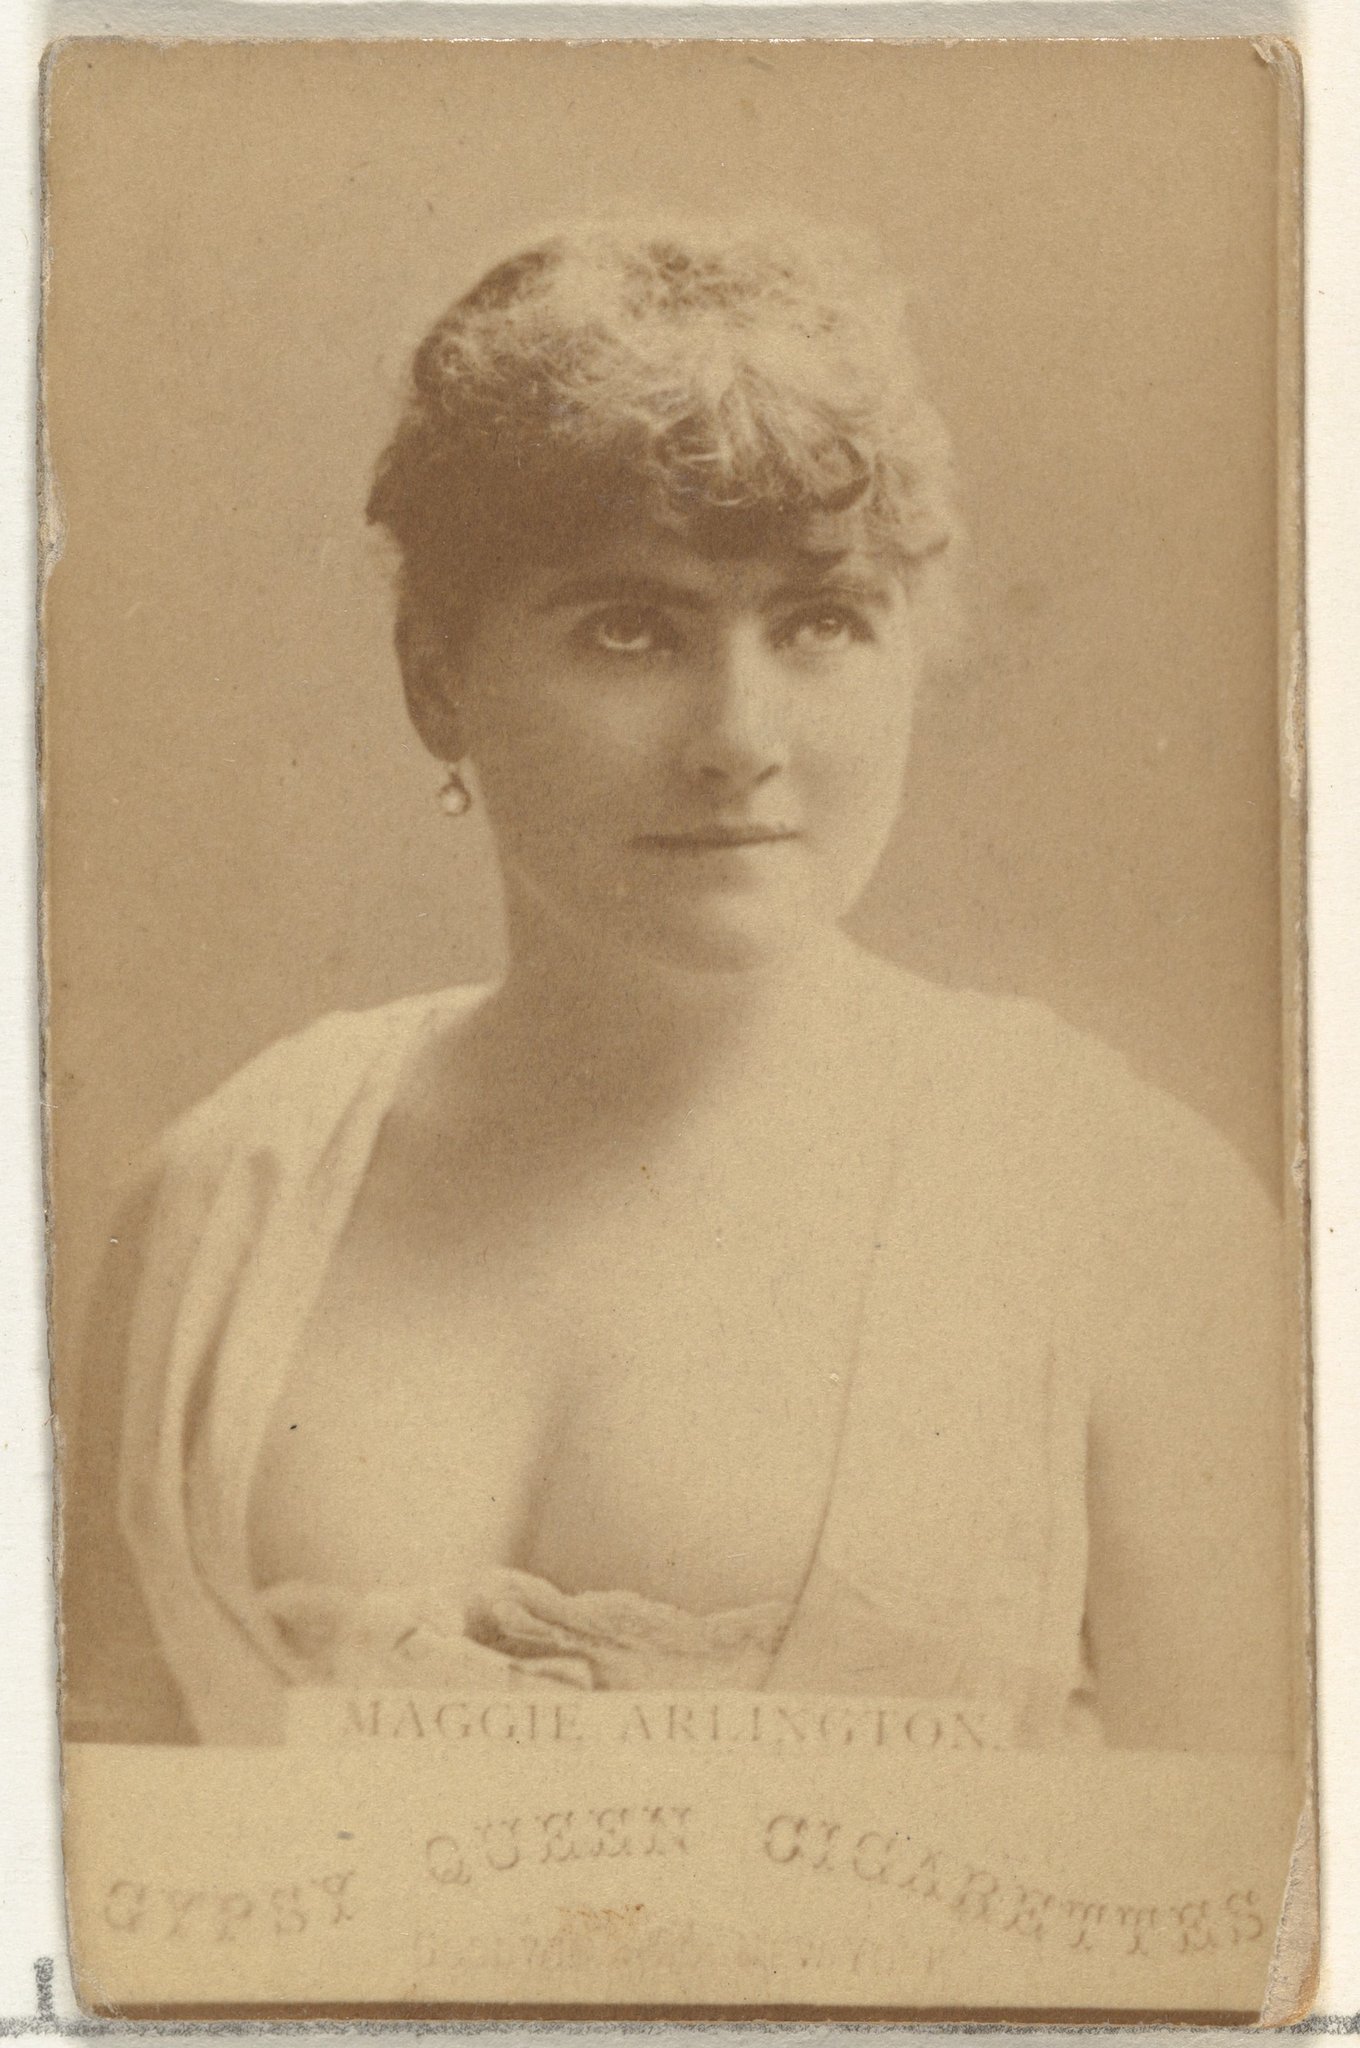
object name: photograph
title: Maggie Arlington, from the Actors and Actresses series (N171) for Gypsy Queen Cigarettes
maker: goodwin & company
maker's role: publisher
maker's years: 1850-1950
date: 1886-1890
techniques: albumen silver print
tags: portraits,women,actresses